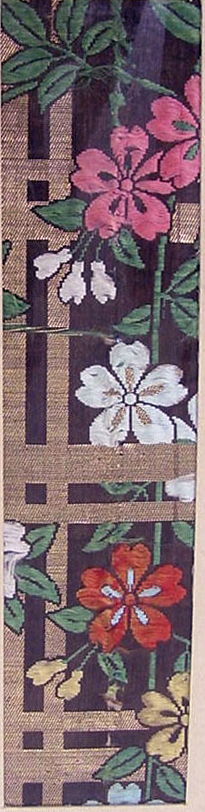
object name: piece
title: Textile with Blossoming Cherry Branches and Lattice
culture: japanese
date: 1615-1868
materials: metal thread, silk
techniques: brocade, patterning, weave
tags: flowers